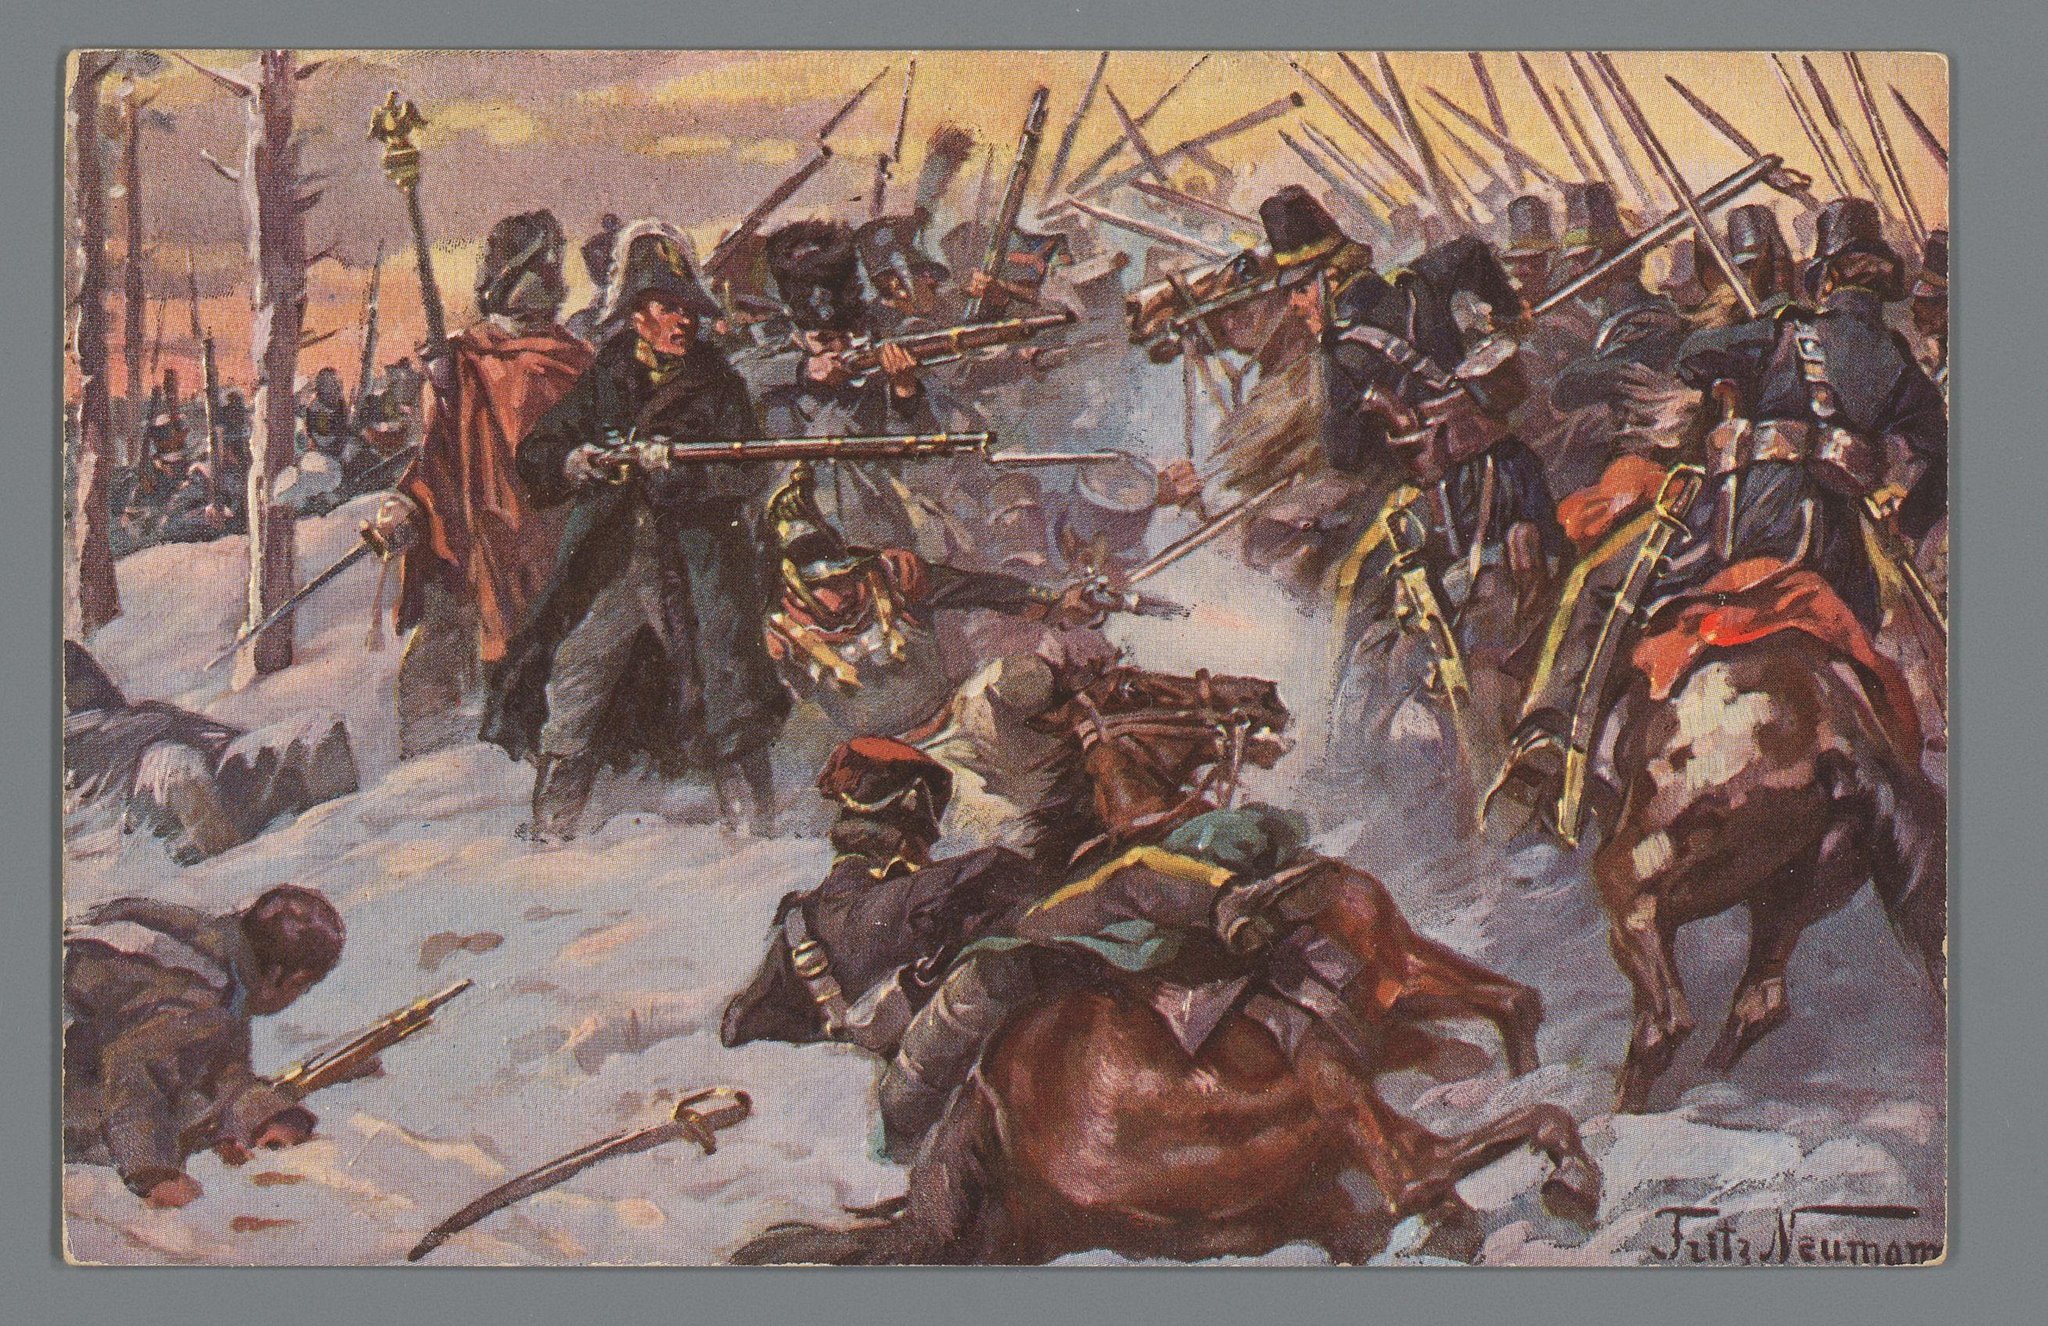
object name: ansichtkaart, prentbriefkaart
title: Bataille de Krasnoi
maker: fritz neumann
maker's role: printer, publisher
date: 1905-1920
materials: cardboard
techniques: three-color autotype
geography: germany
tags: battle, battle of krasnoi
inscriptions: title: ‘1812 r. [Cyrillisch schrift]/ Bataille de Krasnoi./ Schlacht bei Krasnoi.’, inscription: ‘68, oorlog’, inscription: ‘Marke E.G.M.S. Serie 105.’